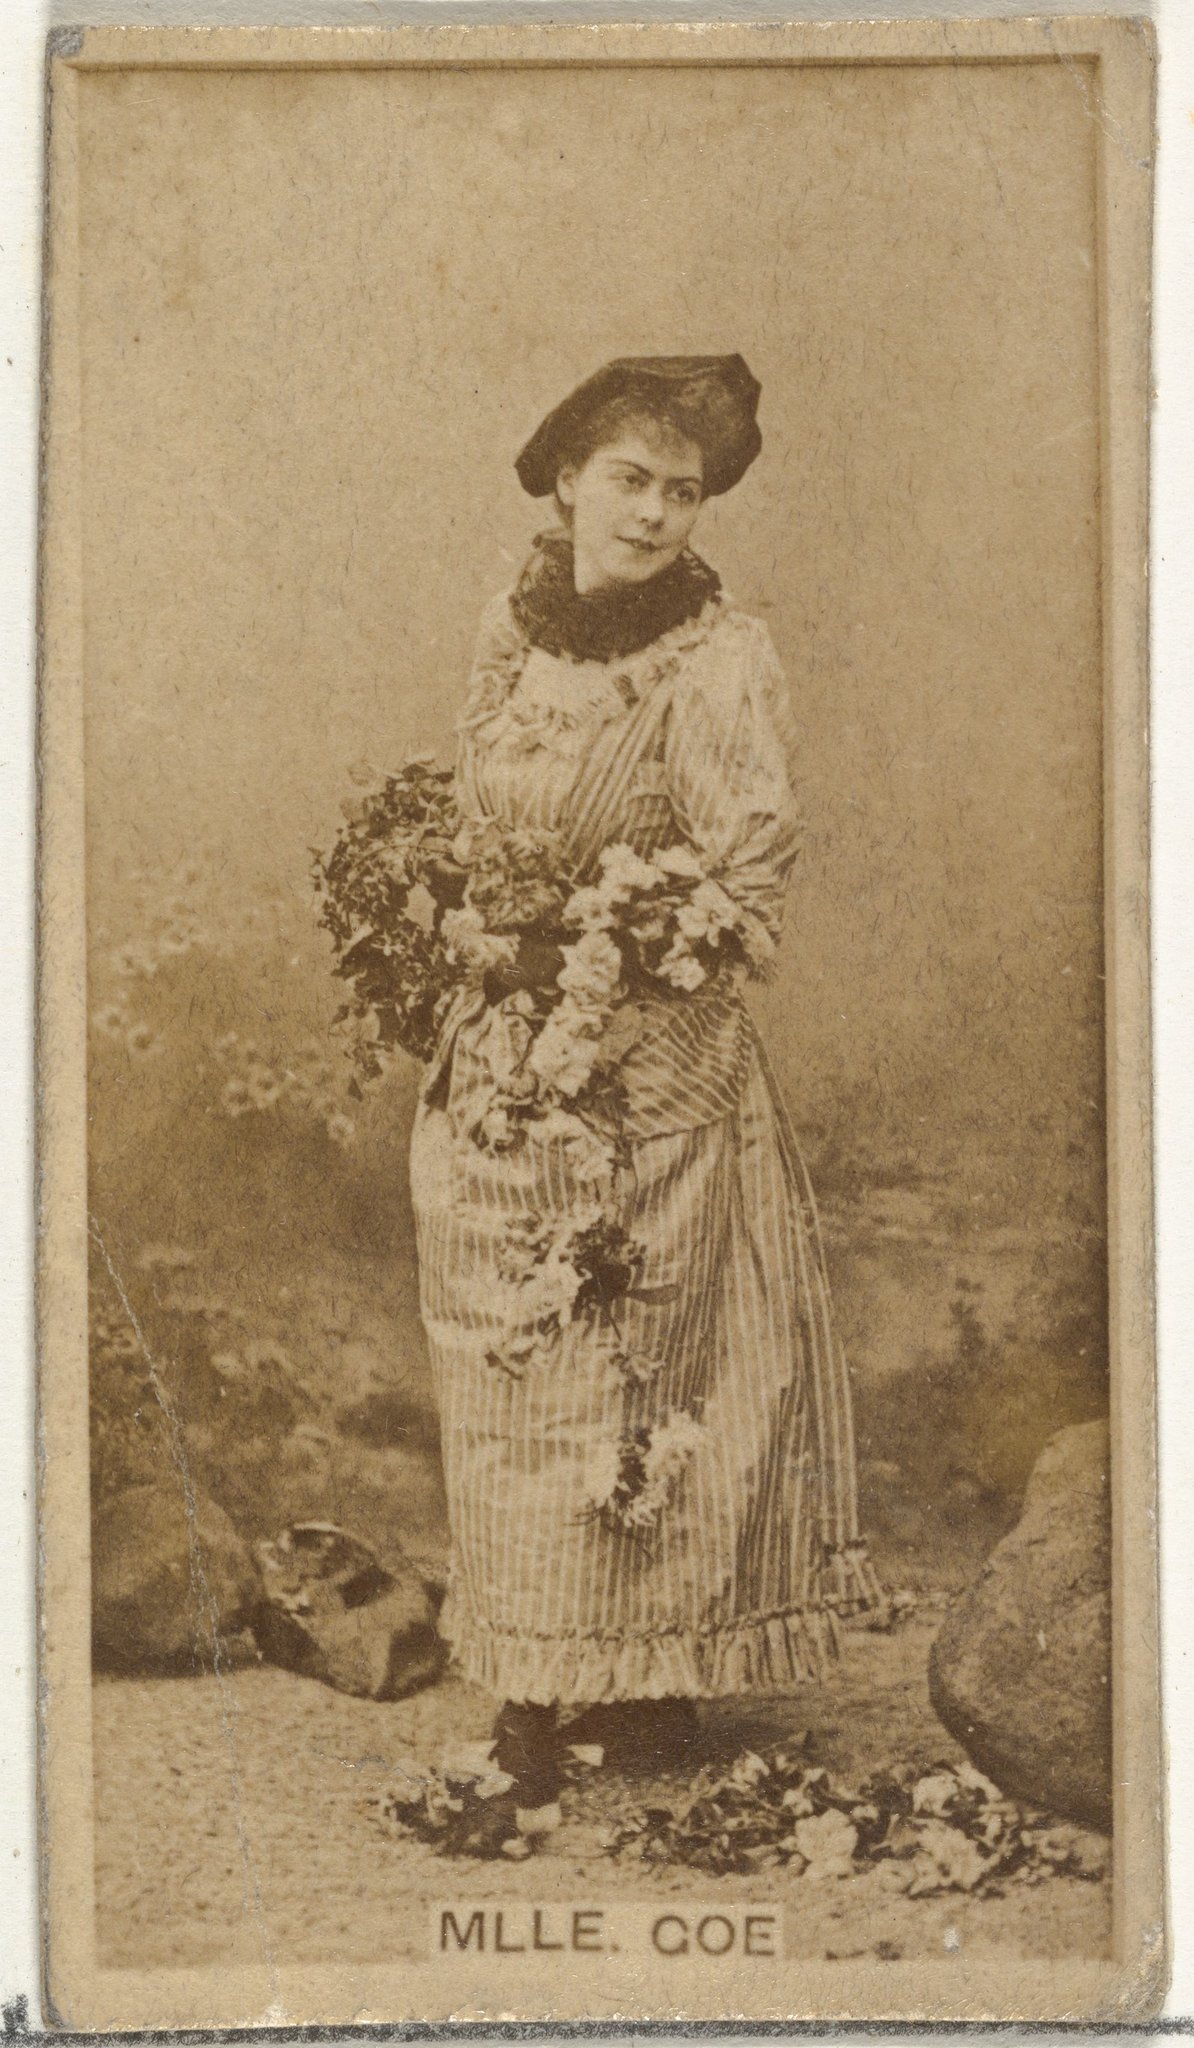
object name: photograph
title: Miss Isabelle Coe, from the Actors and Actresses series (N145-8) issued by Duke Sons & Co. to promote Duke Cigarettes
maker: w. duke, sons & co.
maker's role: publisher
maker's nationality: american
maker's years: 1870-1920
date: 1891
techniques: albumen silver print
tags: portraits,women,actresses